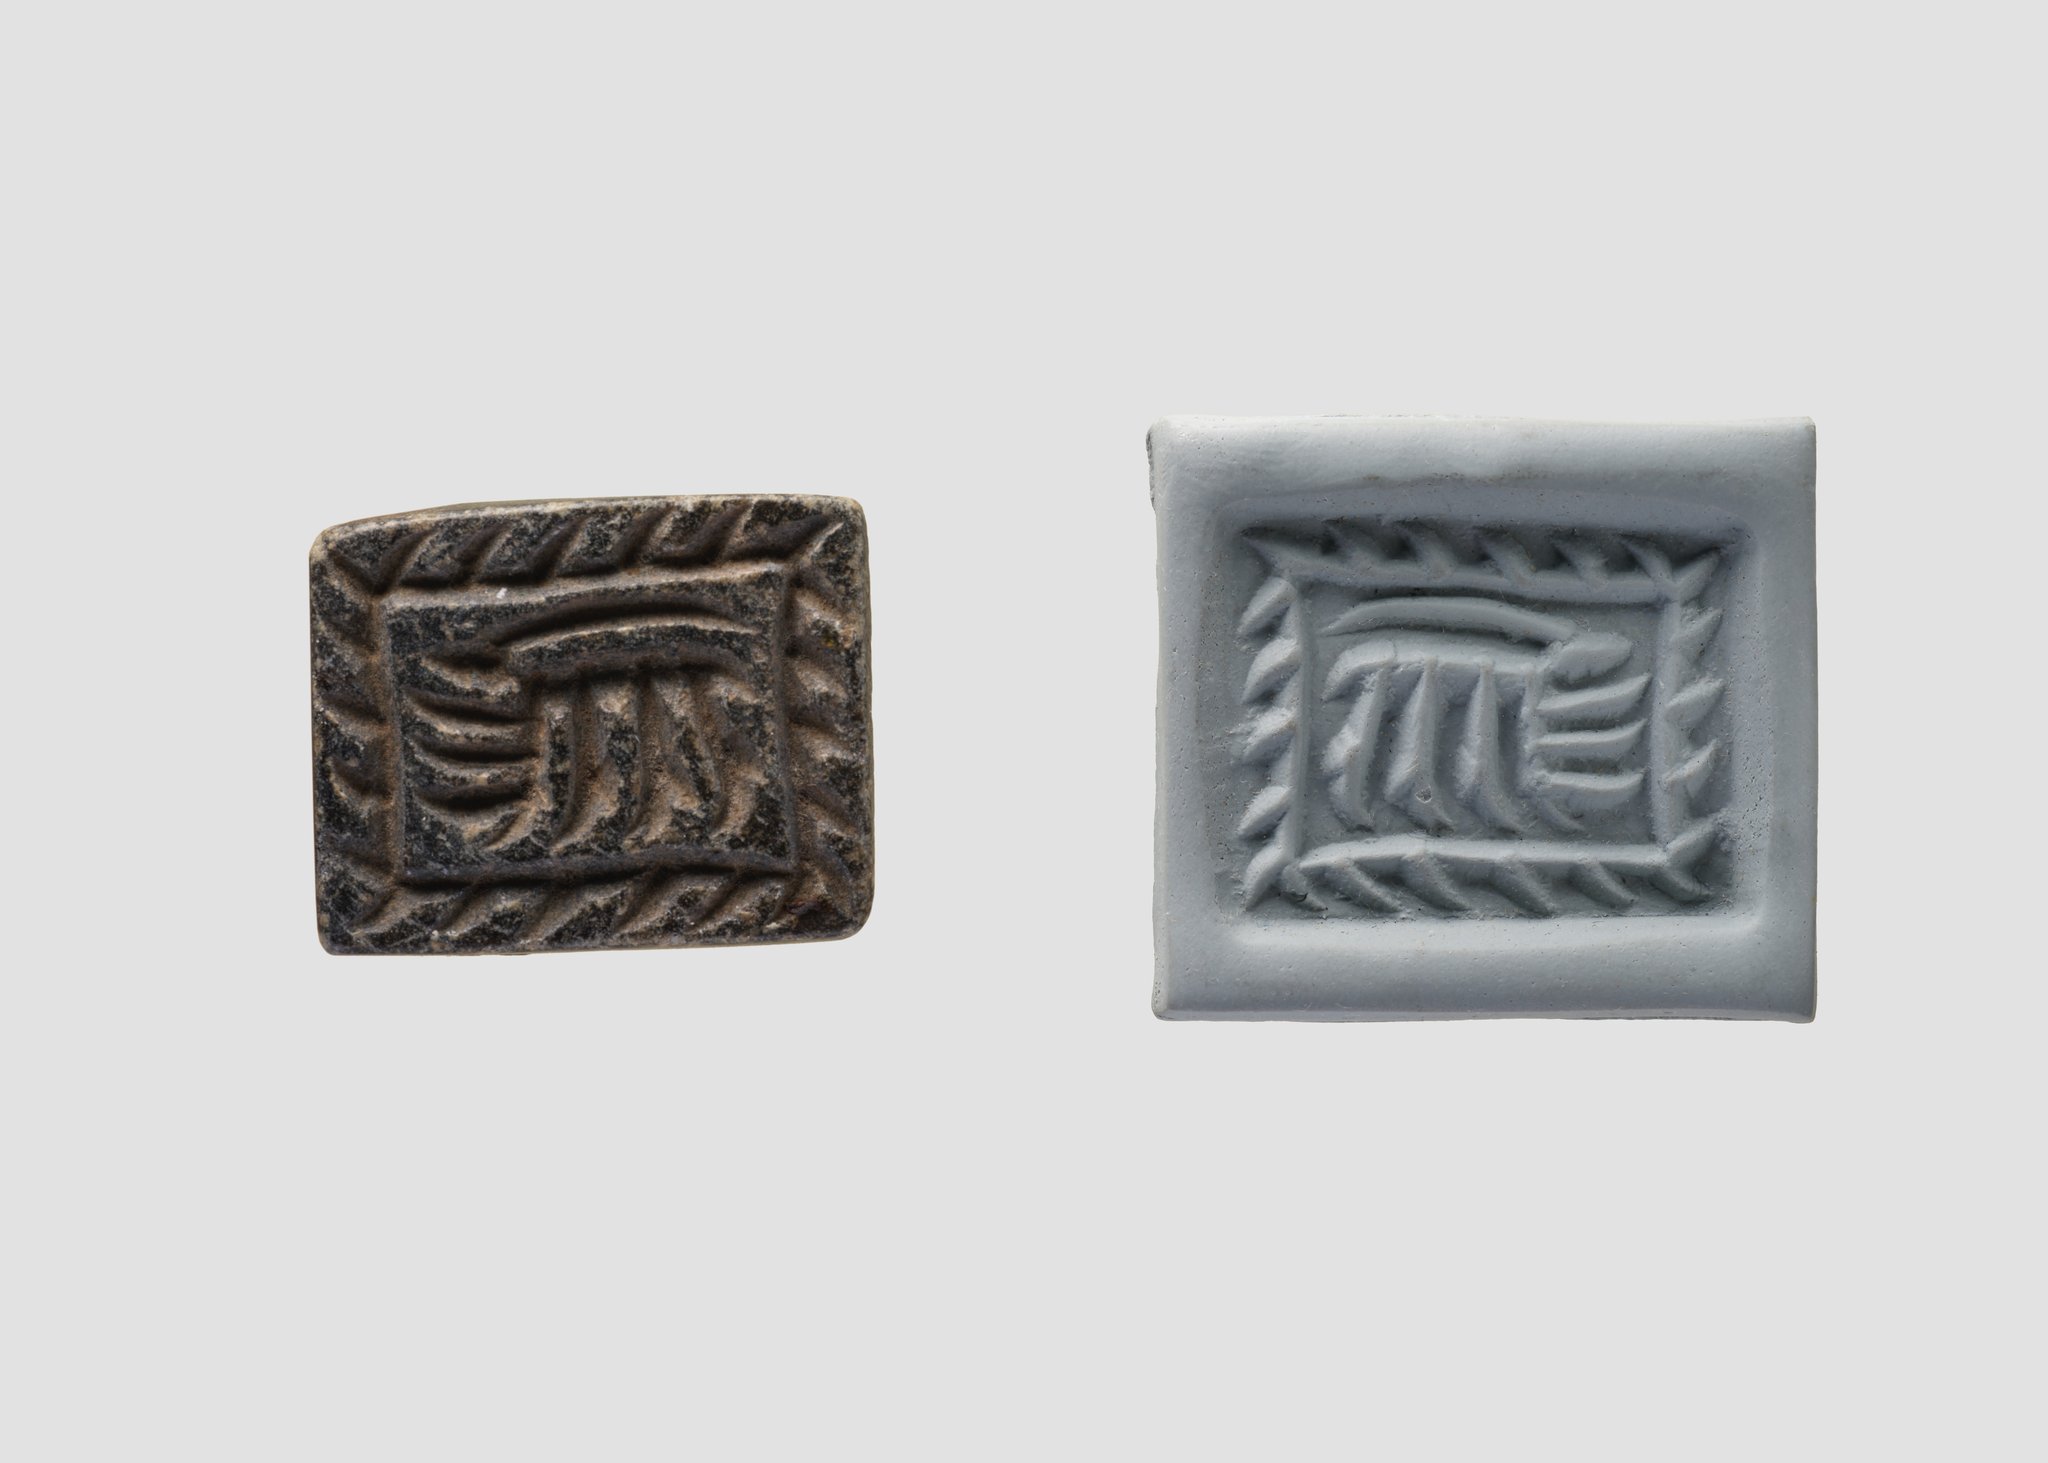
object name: stamp seal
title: Gable seal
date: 4000-3000 BCE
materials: mineral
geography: northern syria or southeastern anatolia